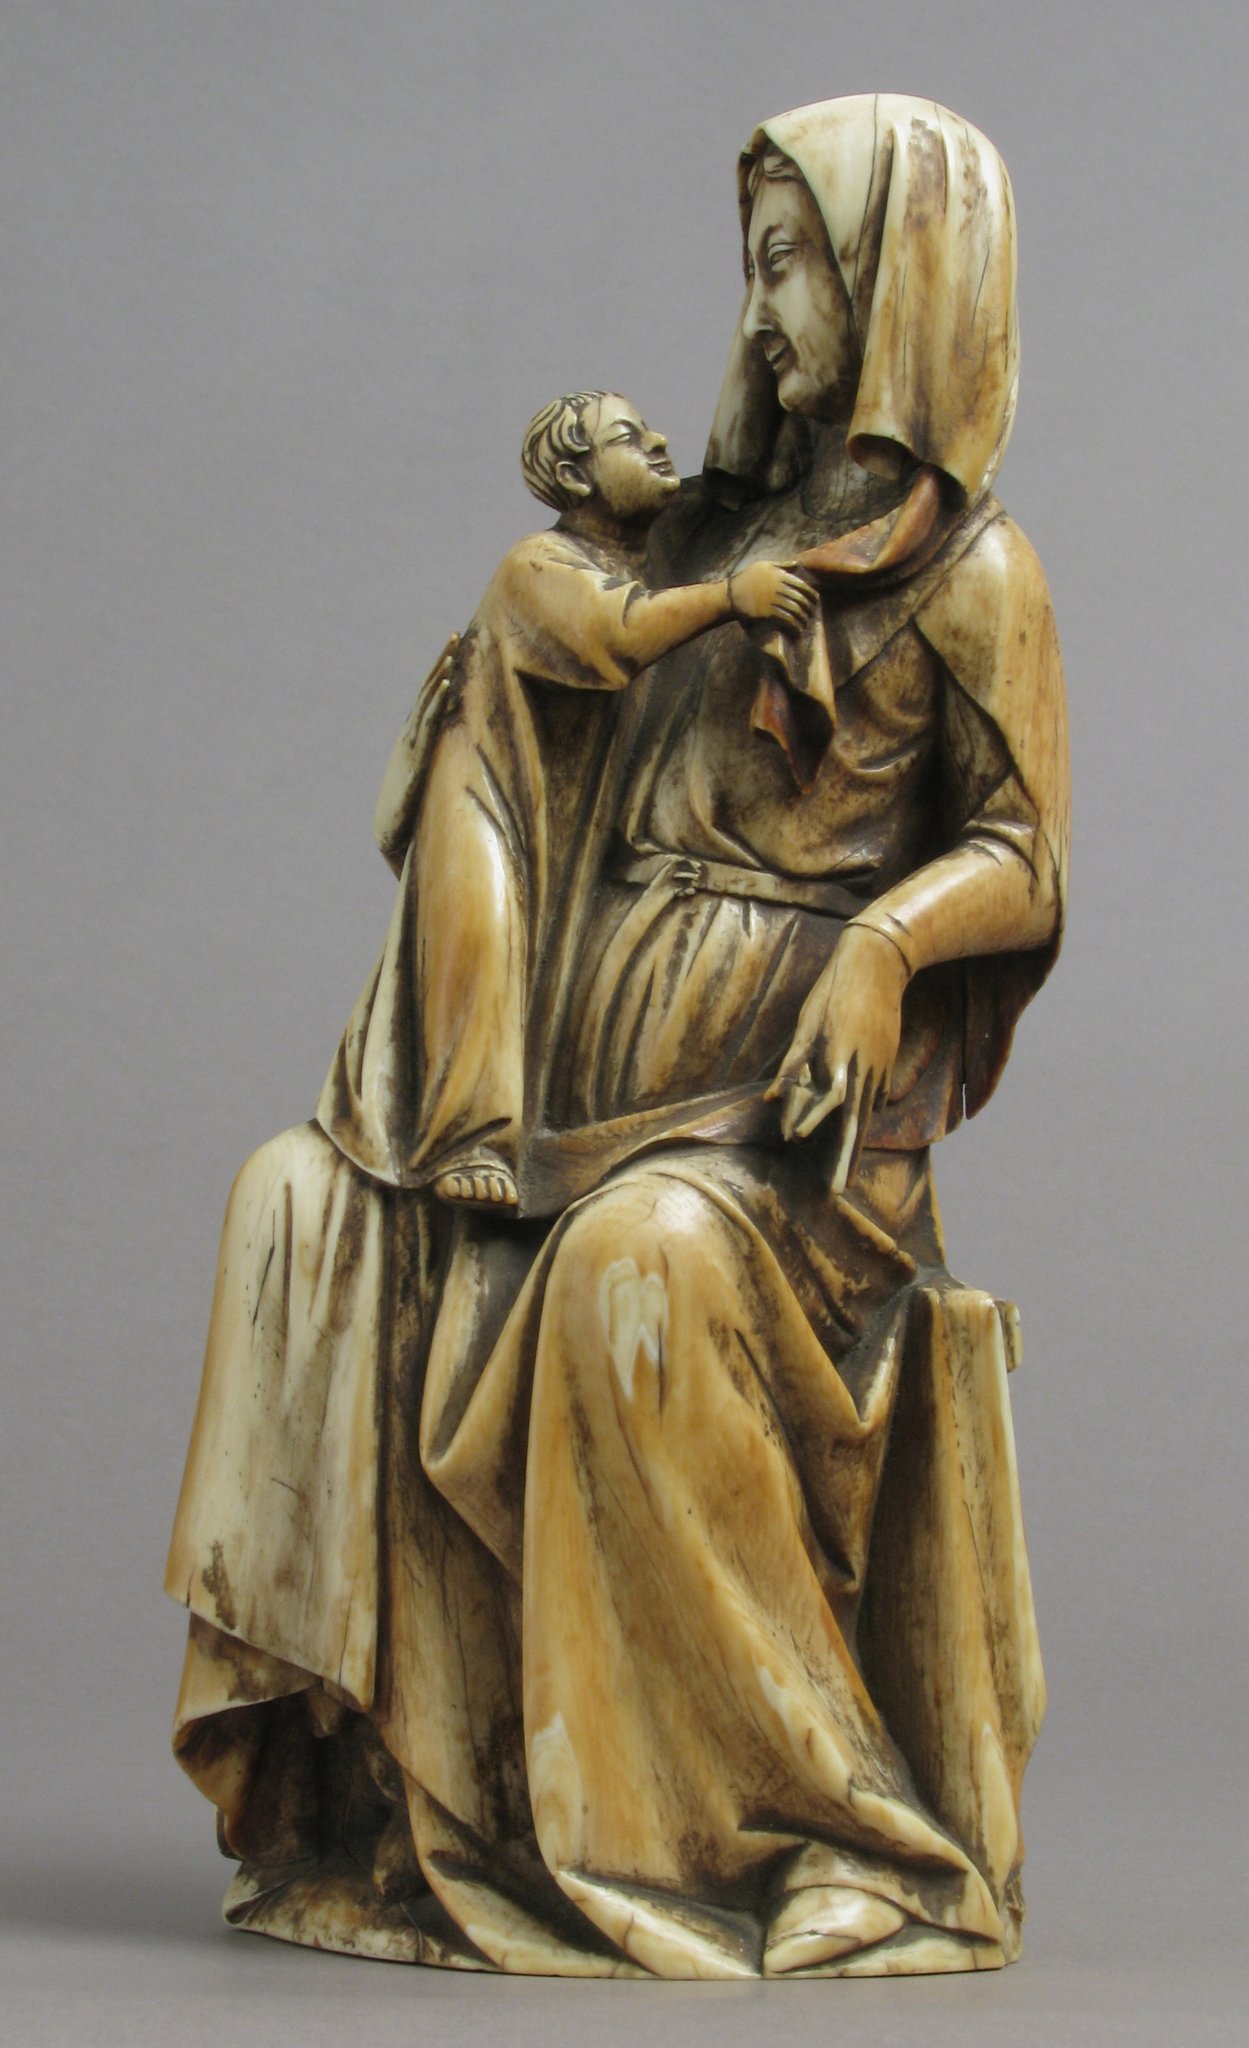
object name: sculpture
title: Virgin and Child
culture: european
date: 1801-1900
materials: ivory